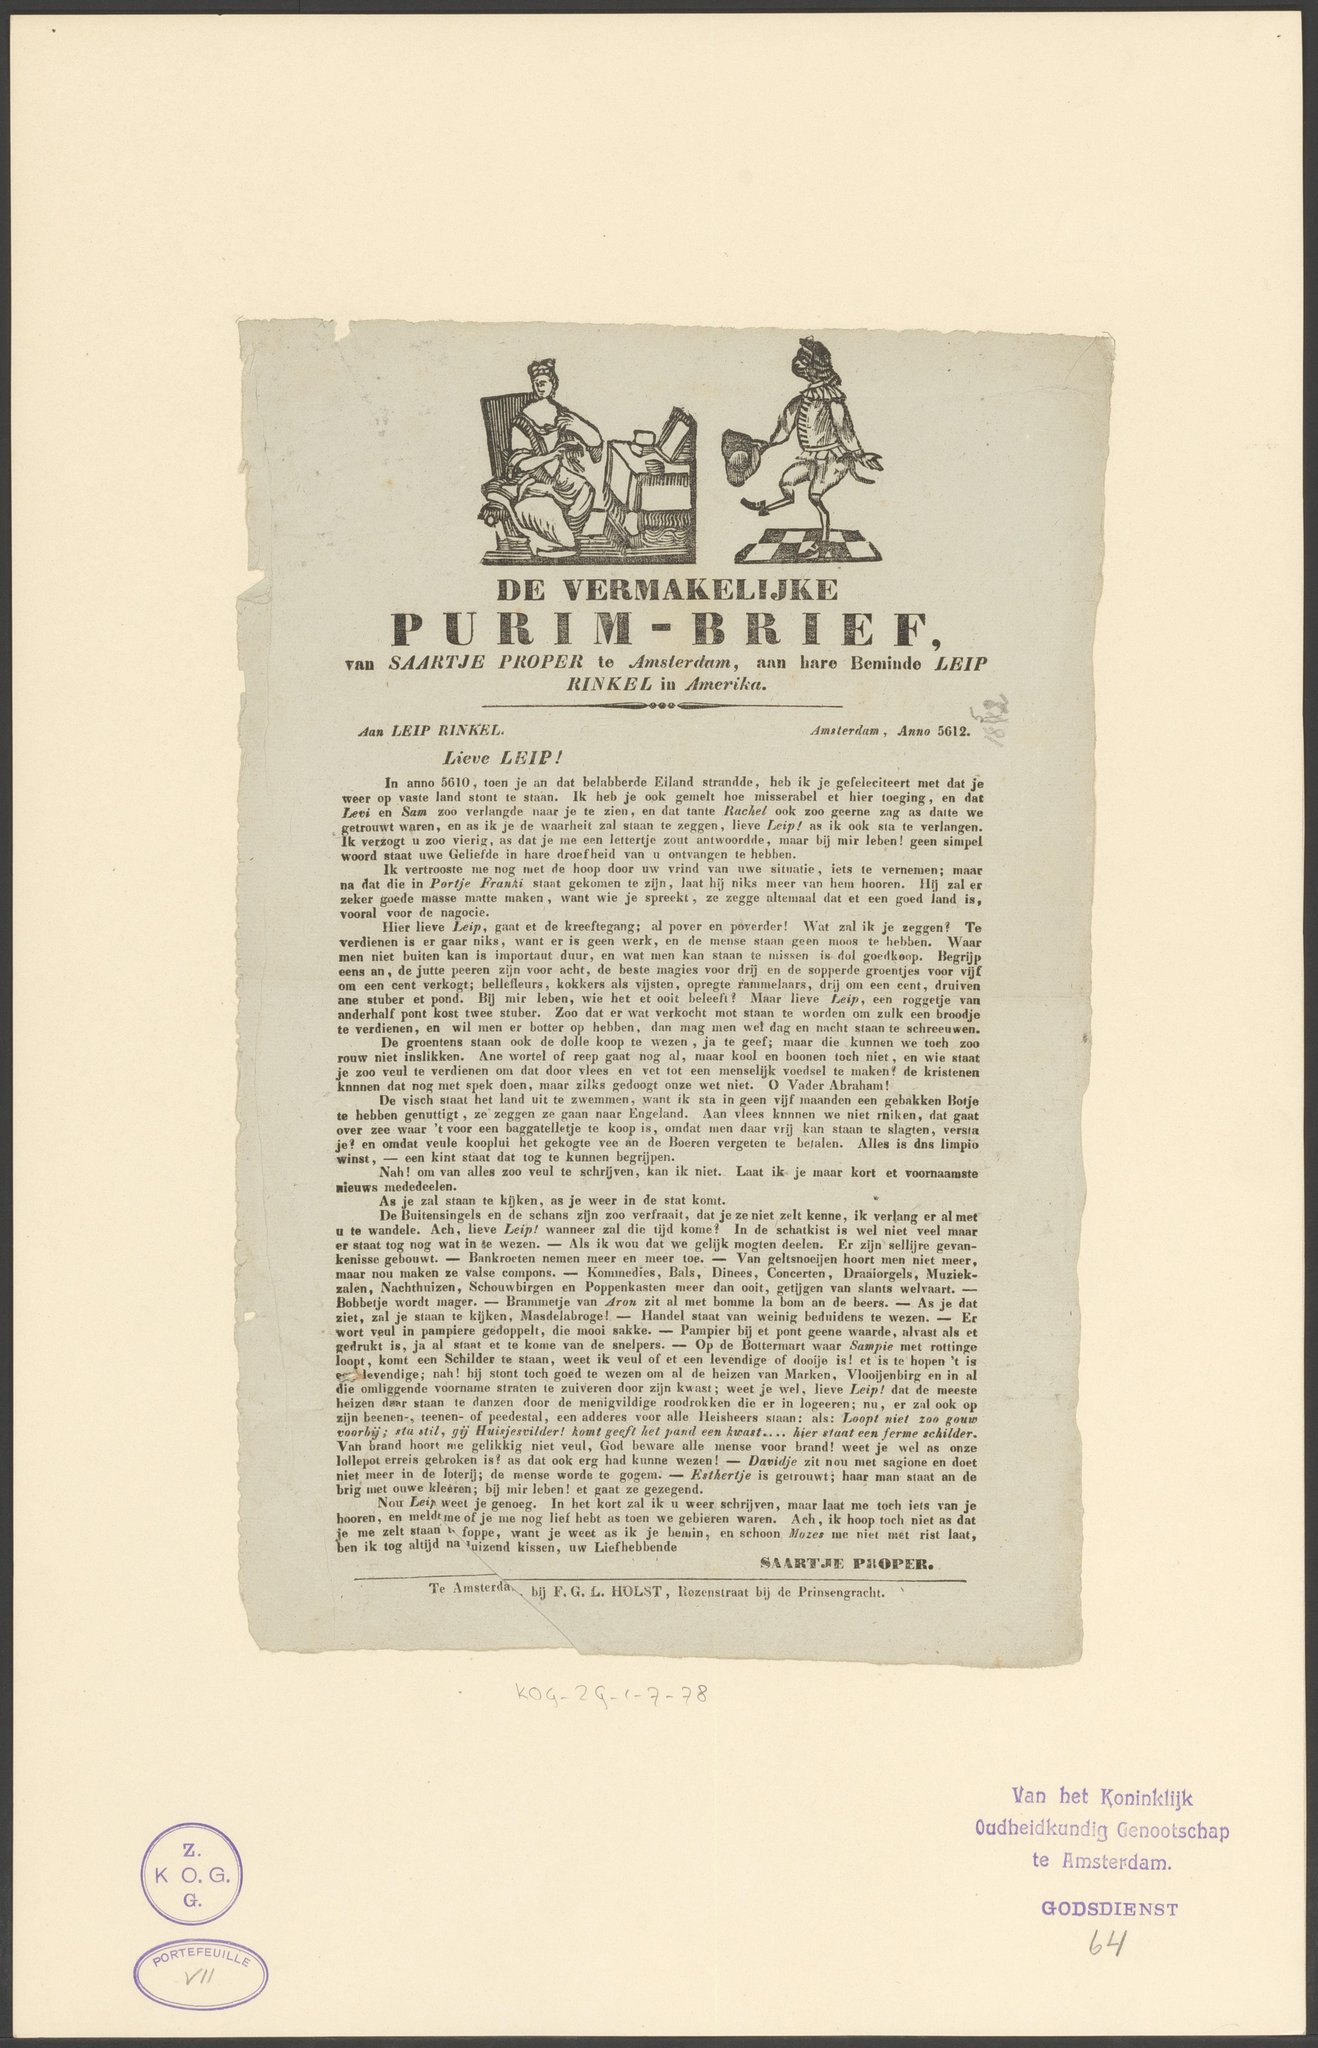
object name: text sheet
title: Poerimbrief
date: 1852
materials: paper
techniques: letterpress printing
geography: amsterdam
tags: samuel beerenstein, aids for prayer, e.g. rosary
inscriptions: stamp, collector's mark: Lugt 1641, stamp: ‘Van het Koninklijk Oudheidkundig Genootschap te Amsterdam’, stamp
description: Pamflet ter gelegenheid van poerim. De tekst is en brief van de fictieve Saartje Proper aan haar geliefde Leip Rinkel in Amerika. In de brief beschrijft zij het leven in Amsterdam en de nieuwtjes over de bewoners van de Joodse buurt in Amsterdam. Onderwerpsrubrieken binnen de Atlas Zeden en Gewoonten: Godsdienst, Israëlieten.